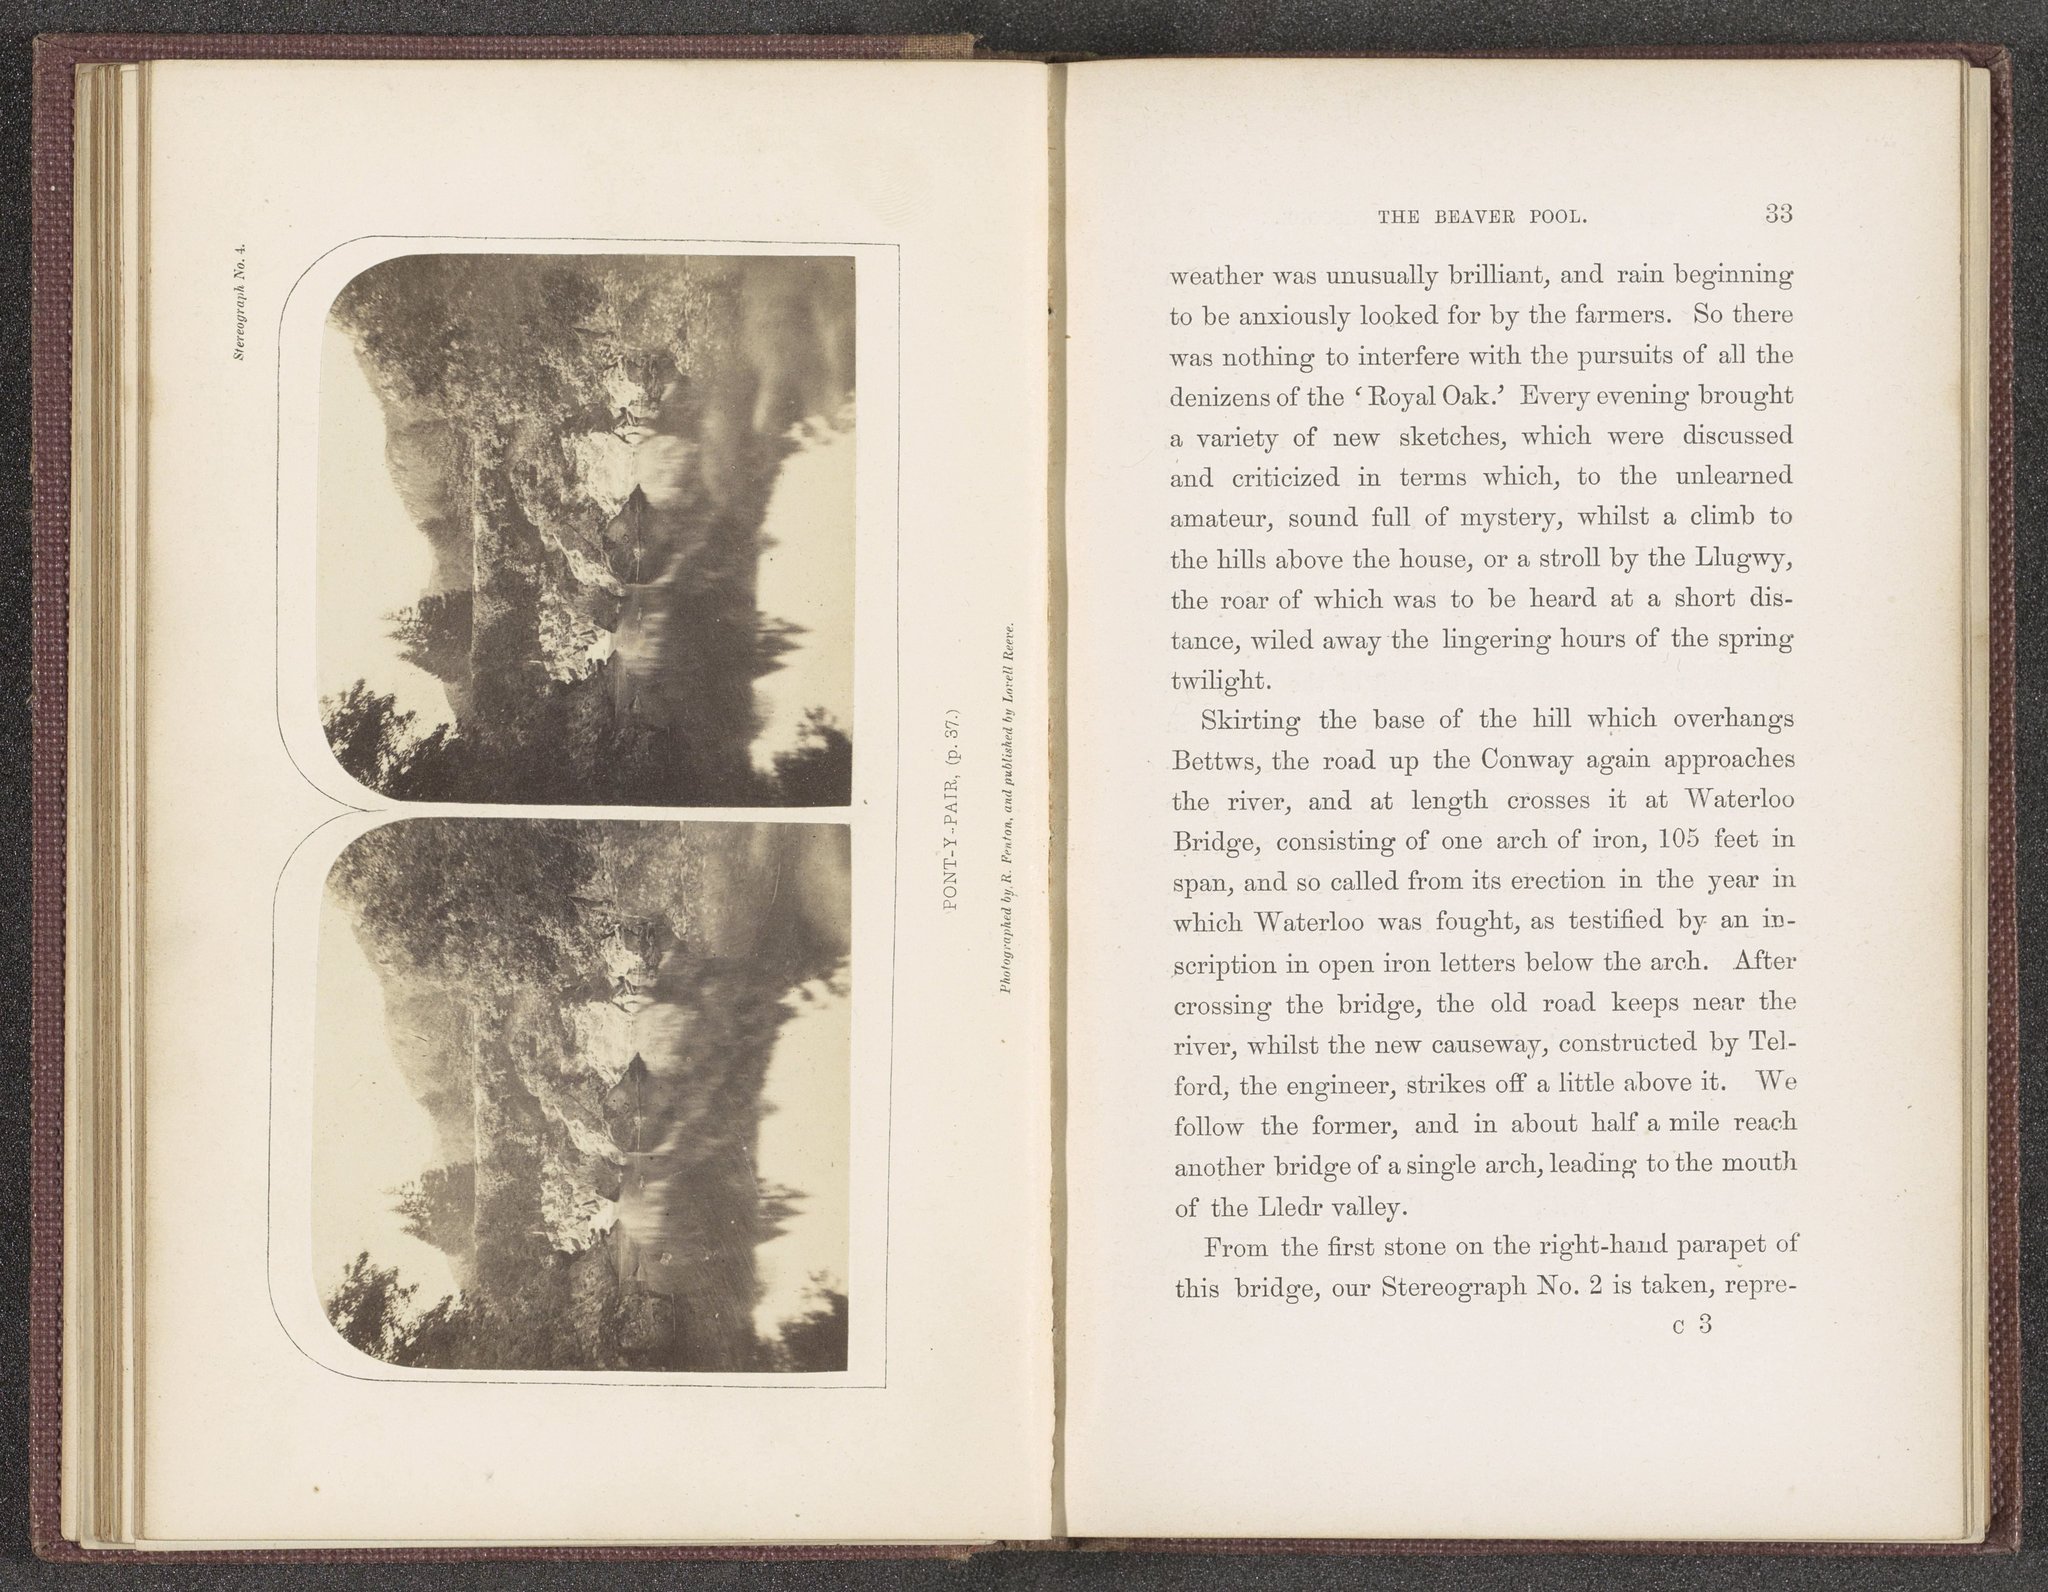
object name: stereograph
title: Pont-Y-Pair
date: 1859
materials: paper, photographic support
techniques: albumen print, printing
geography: wales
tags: lake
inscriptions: number: ‘Stereograph No. 4.’